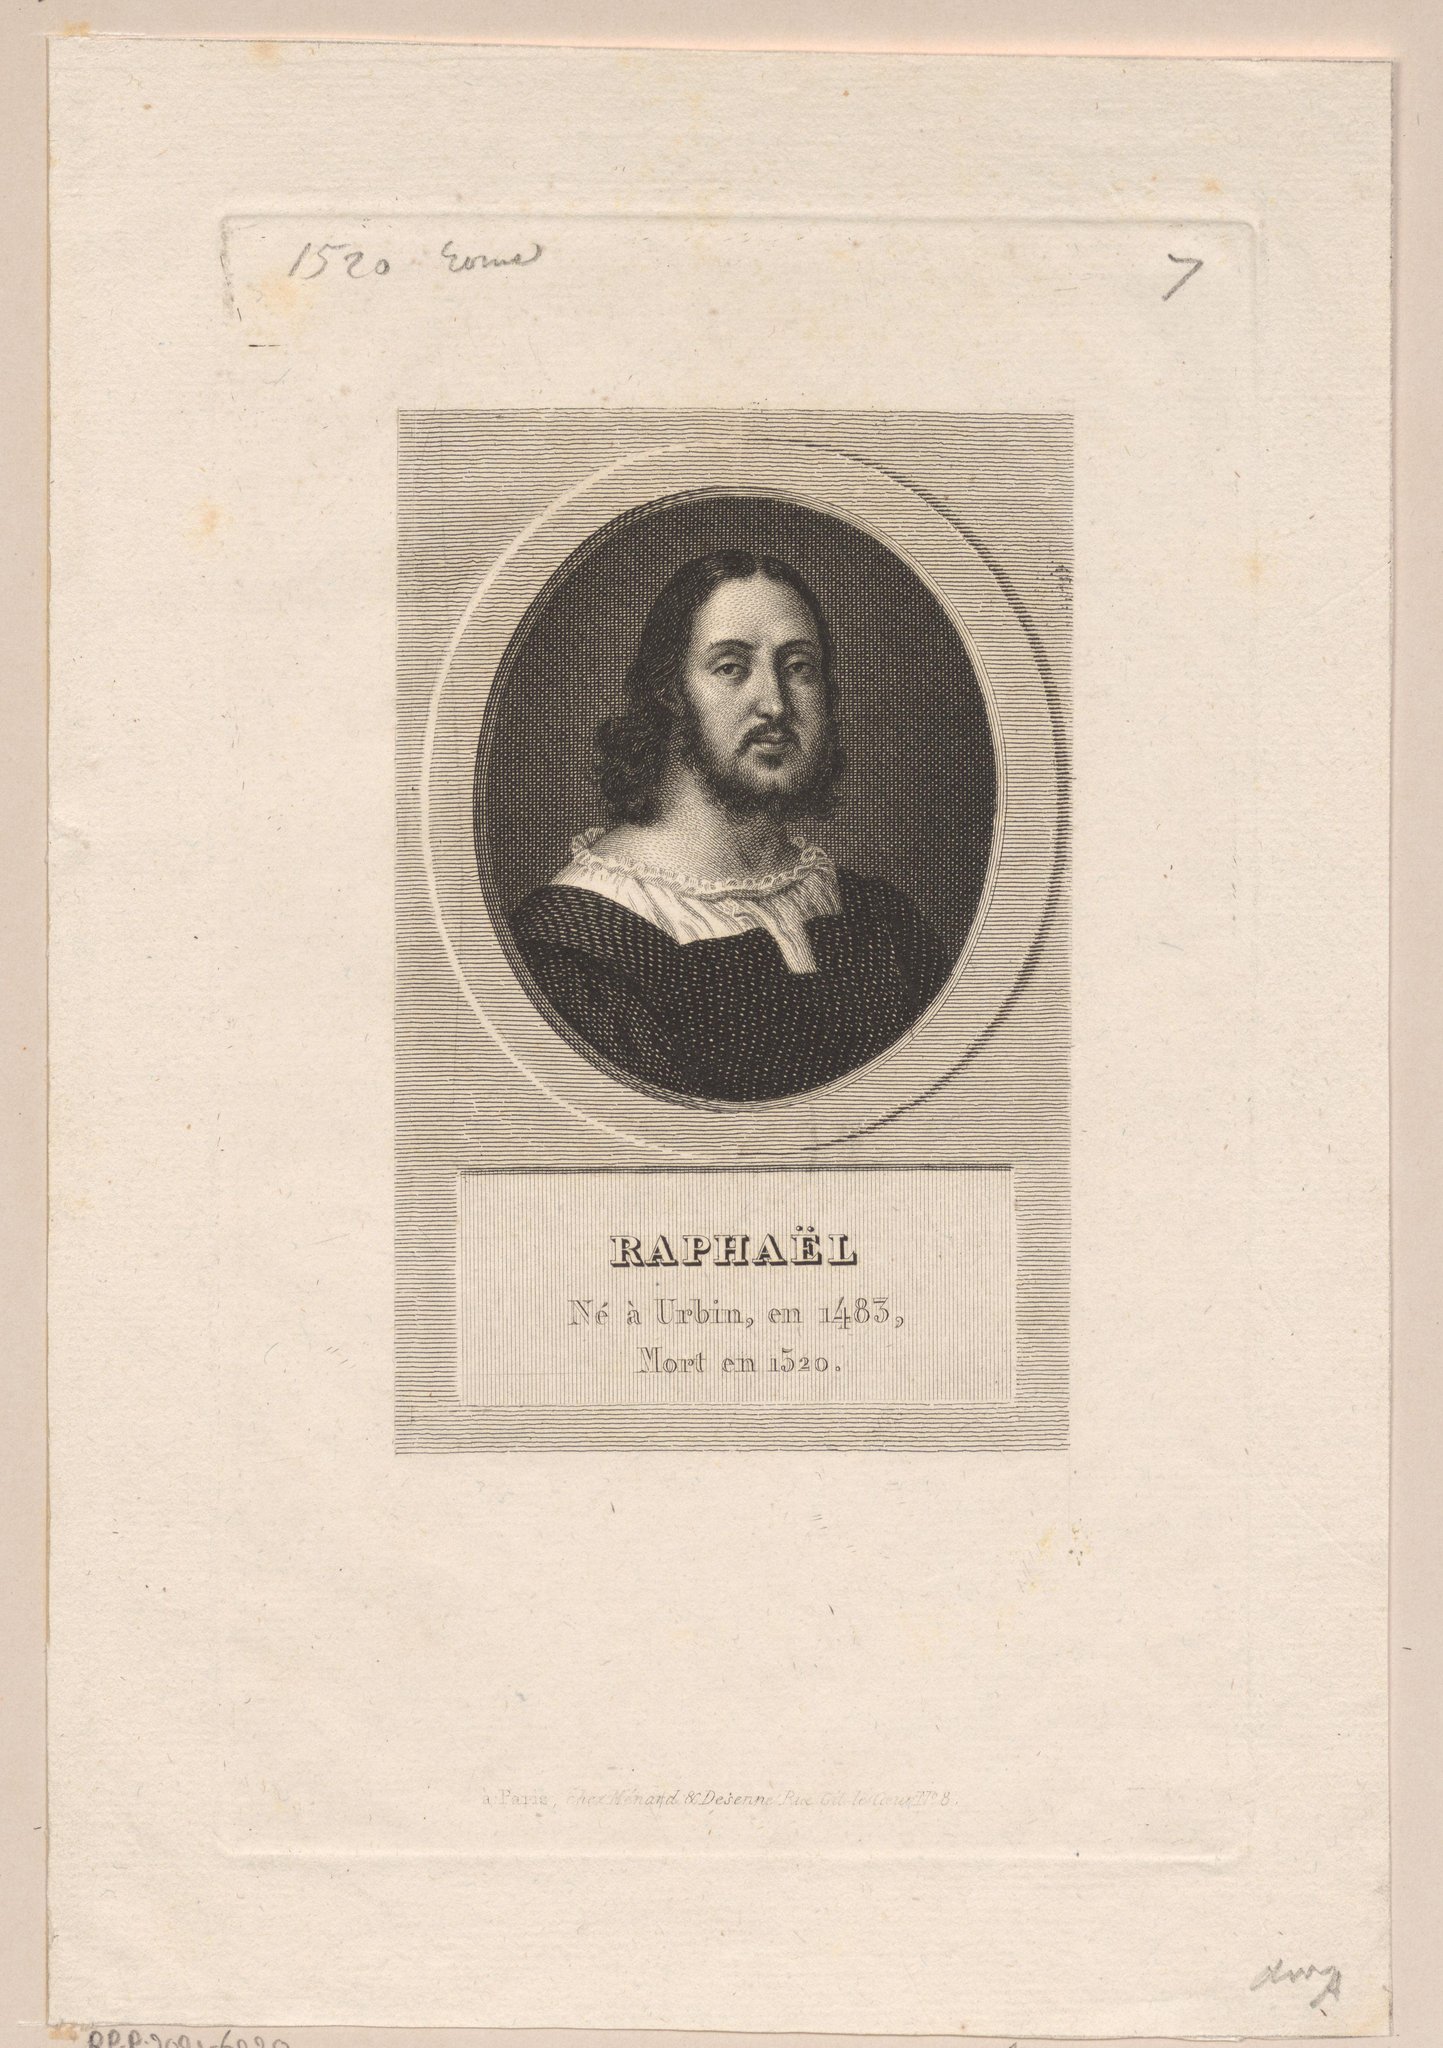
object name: print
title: Portret van Rafaël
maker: Anonymous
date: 1816-1831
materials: paper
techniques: engraving, etching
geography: paris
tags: painter, rafaël, historical persons, portrait, self-portrait of painter